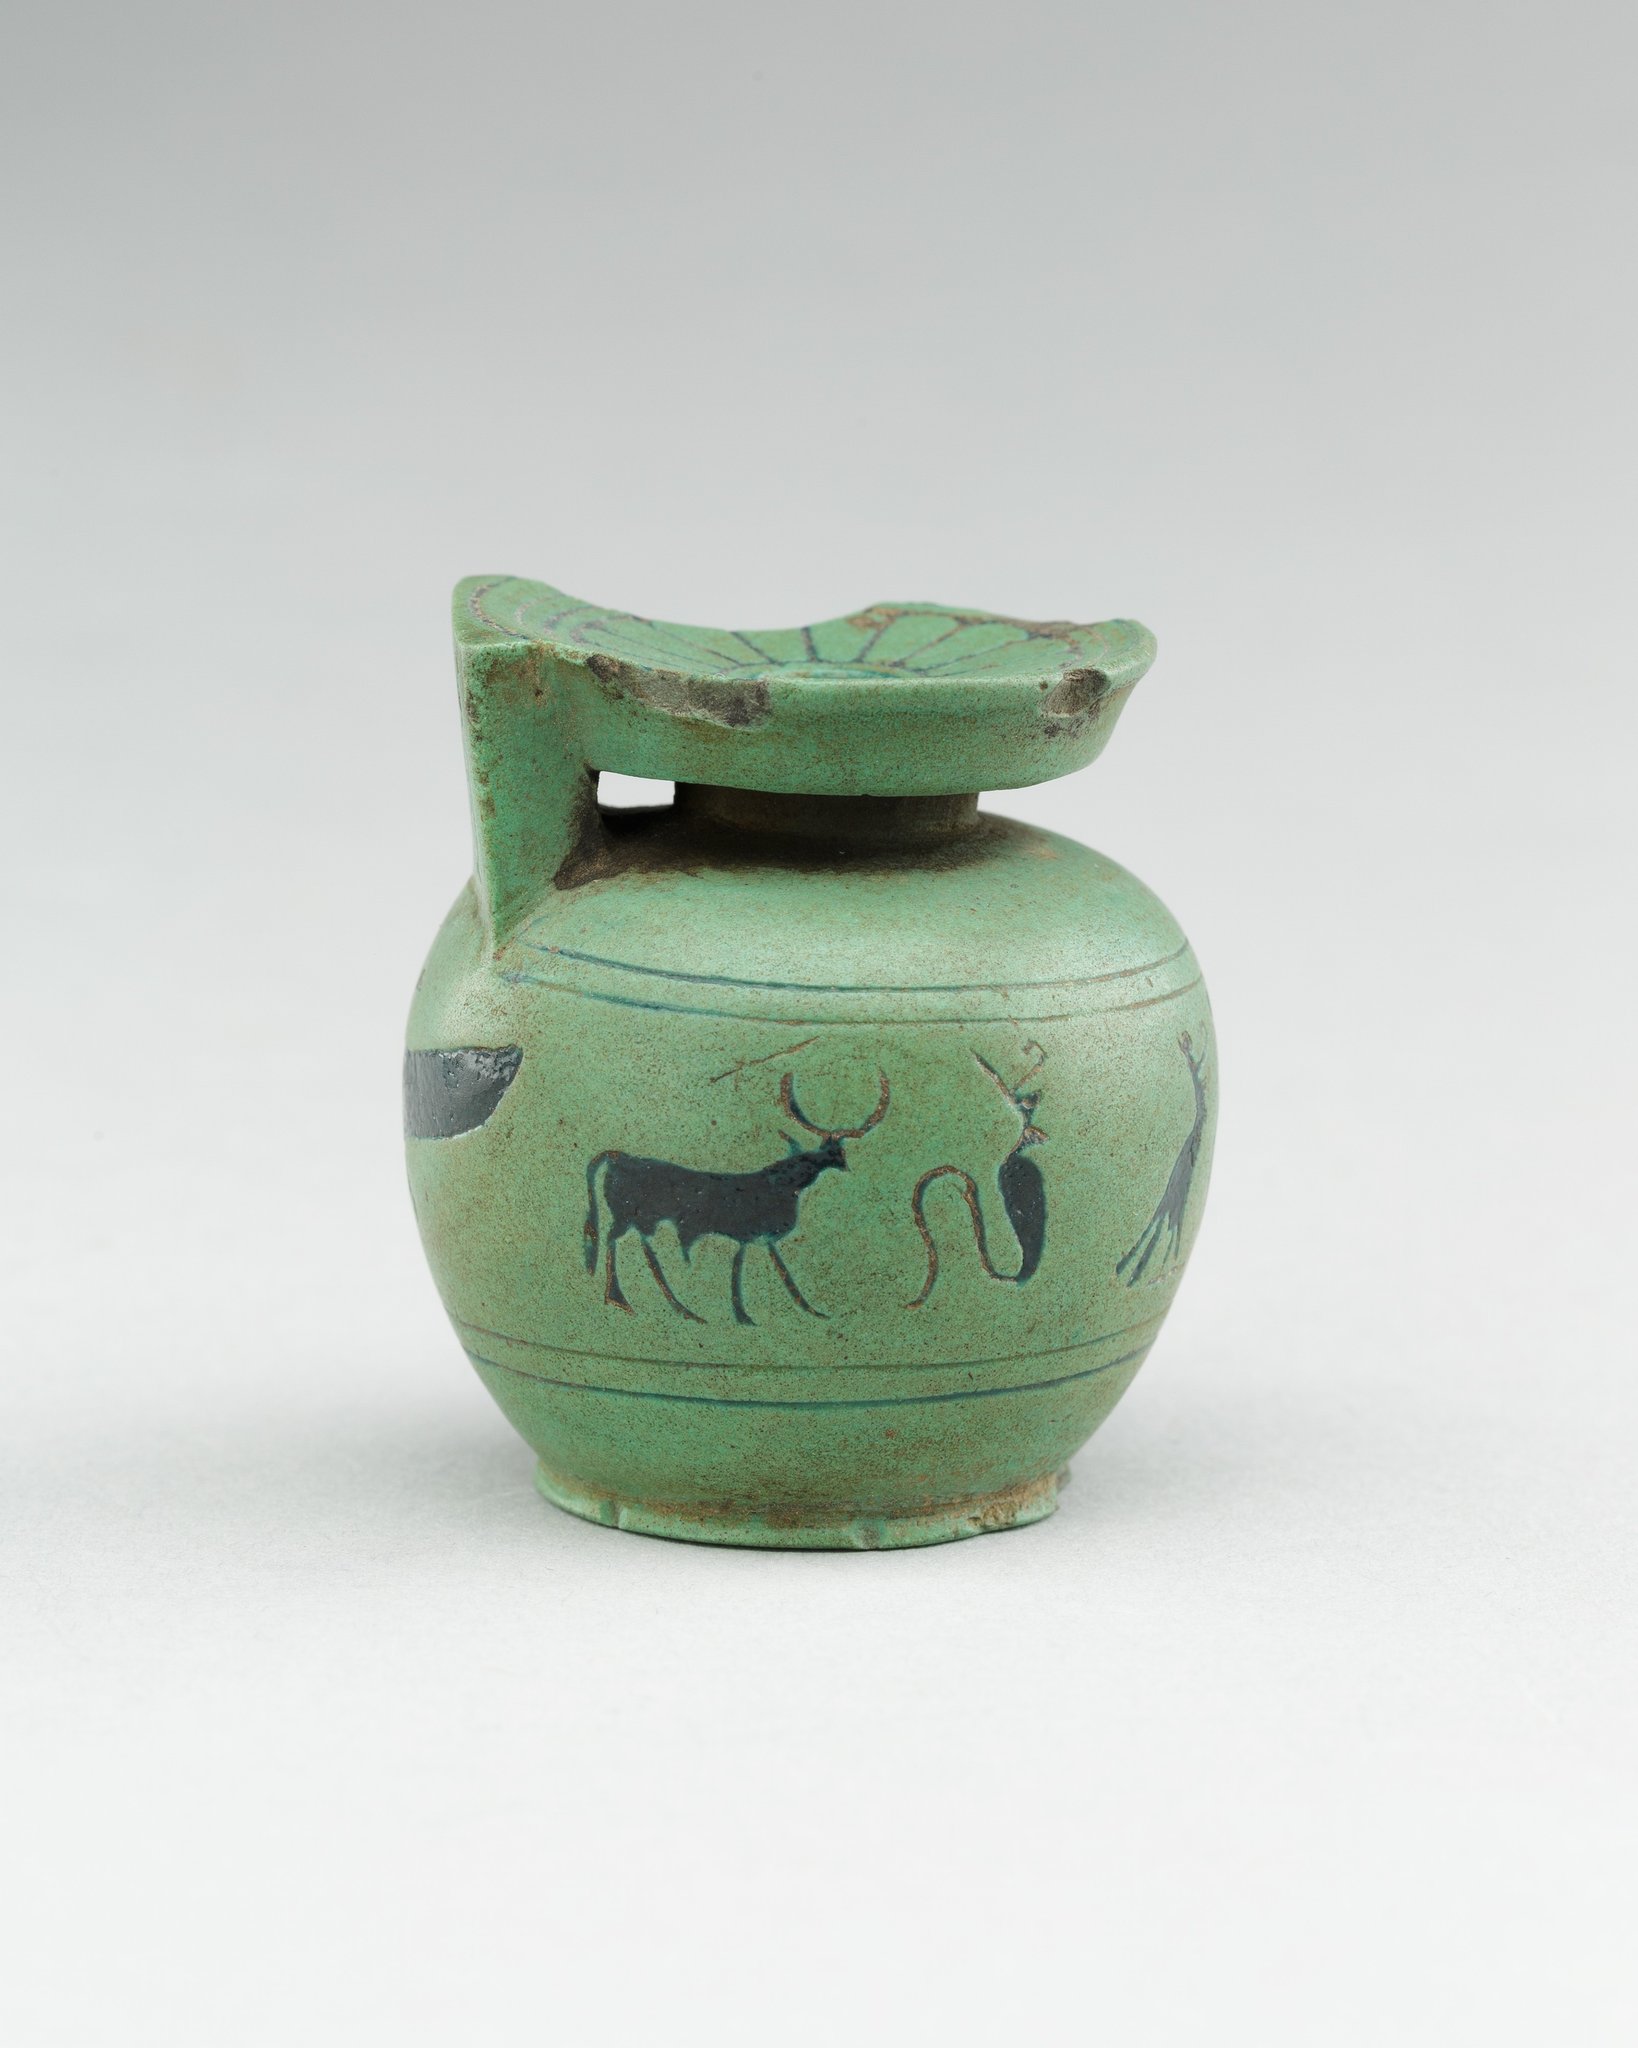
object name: aryballos with the name wahibre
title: Aryballos with the name Wahibre, probably in this instance refering to Apries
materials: faience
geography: egypt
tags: animals